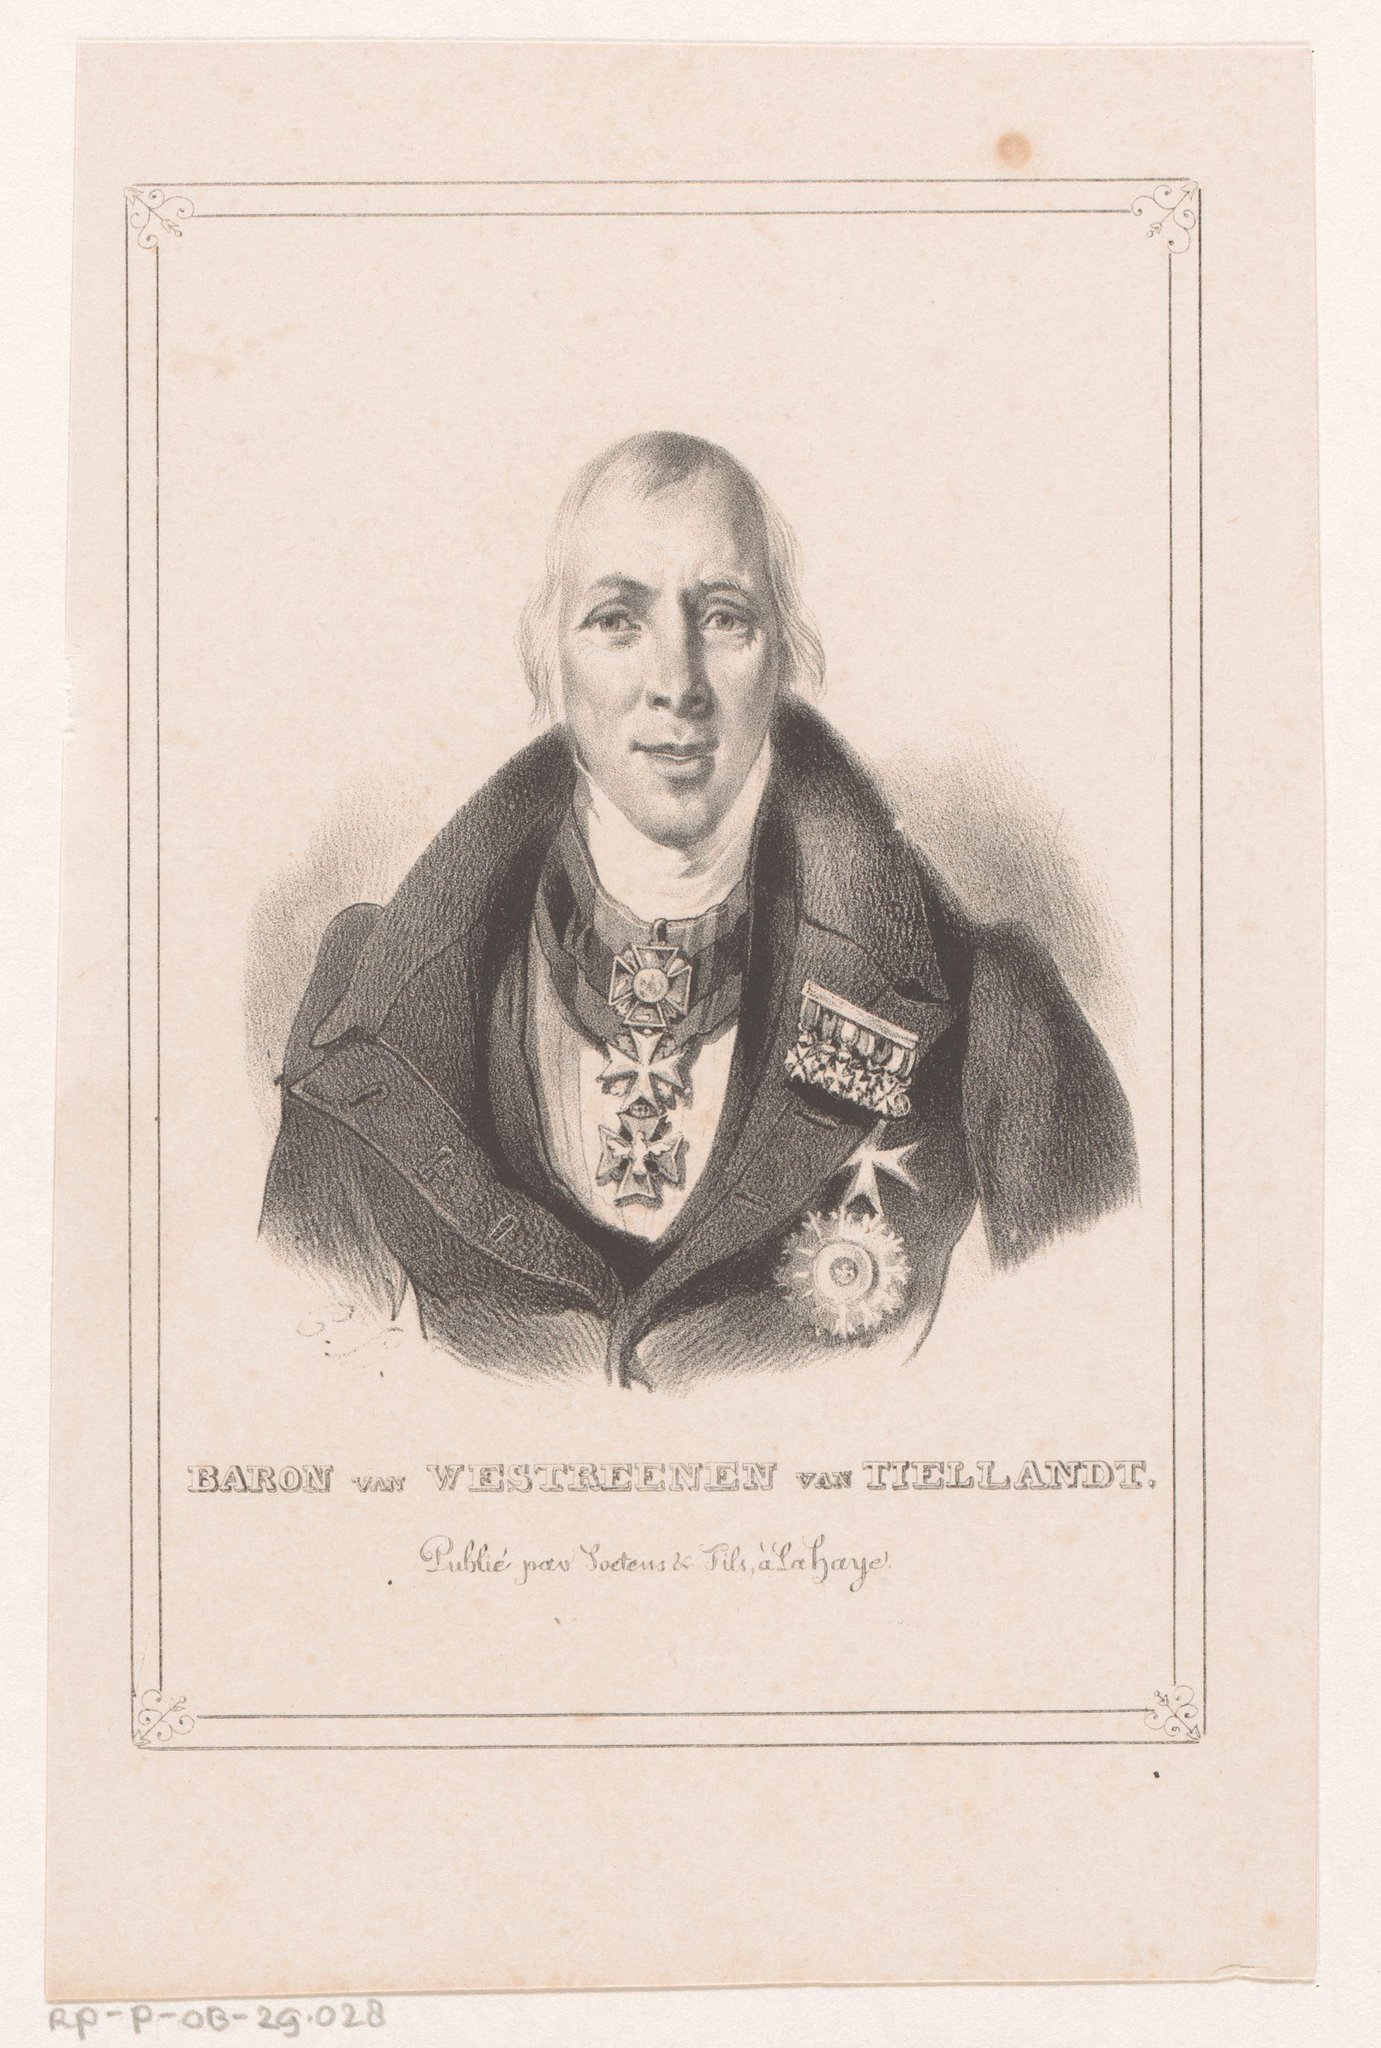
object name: print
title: Portret van Willem Hendrik van Westreenen van Tiellandt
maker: carel christiaan antony last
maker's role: print maker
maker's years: 1808-1876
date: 1837-1840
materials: paper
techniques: lithograph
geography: the hague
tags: the hague, willem hendrik baron van westreenen van tiellandt, knighthood order, historical persons (+ (full) bust portrait)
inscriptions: collector's mark: Lugt 2228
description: De geportretteerde draagt ridderorden om zijn hals en op zijn borst.